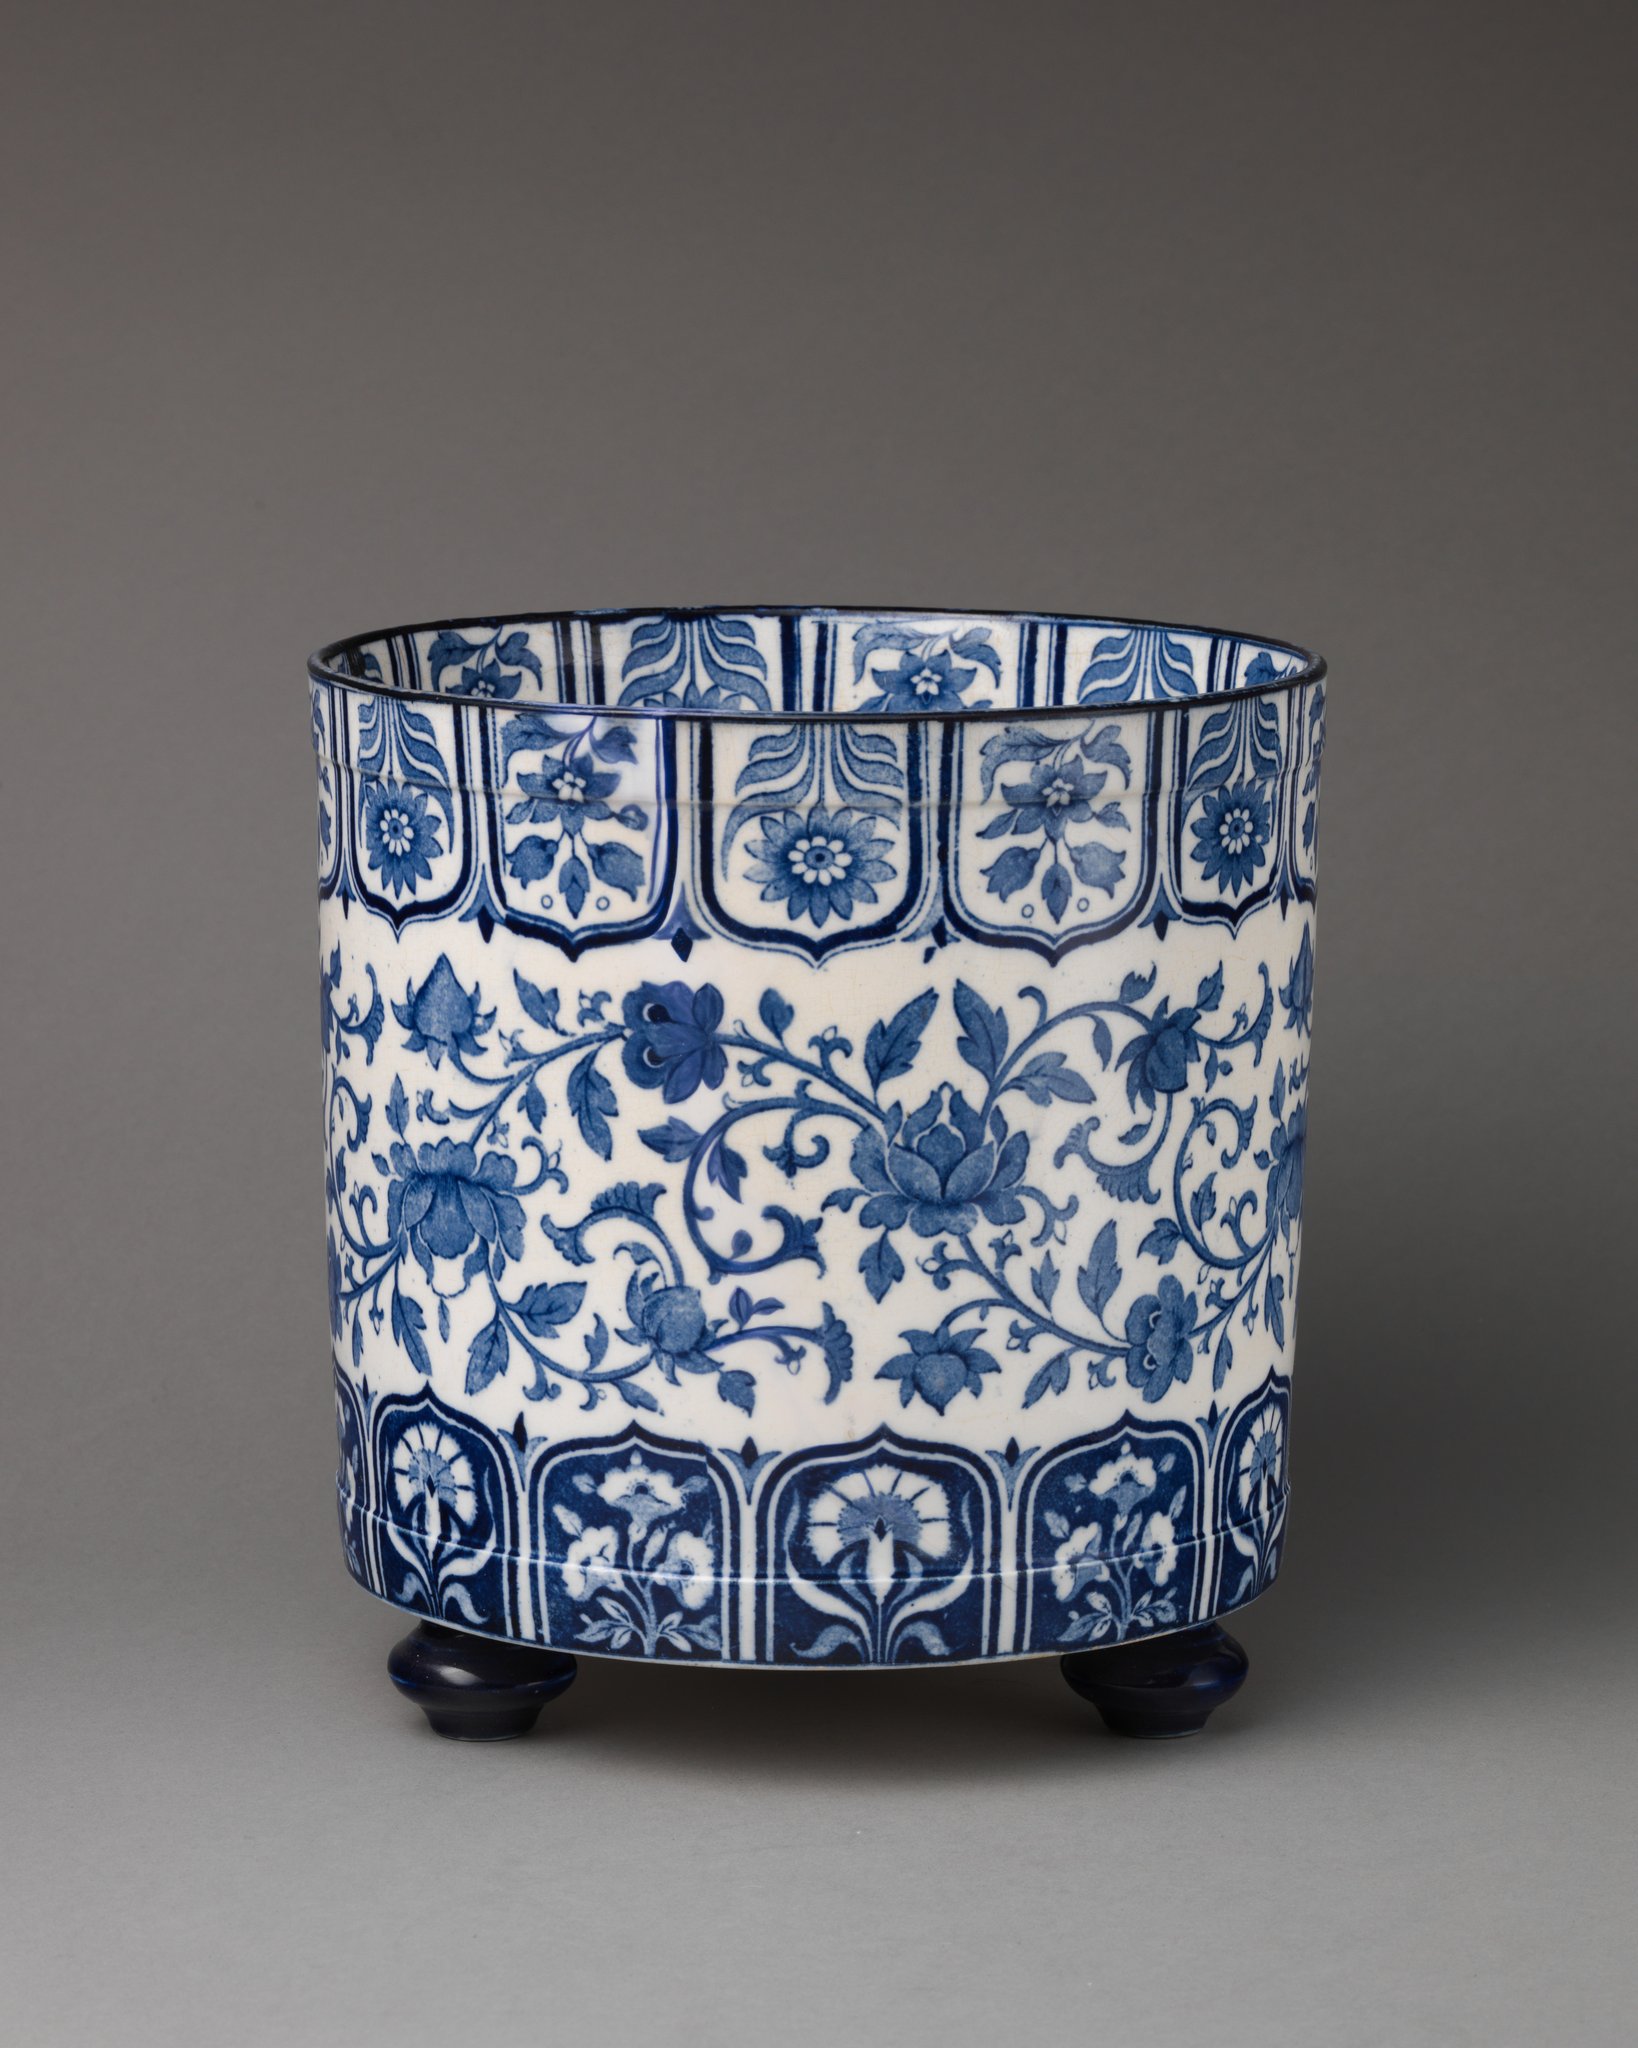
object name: jardinière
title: Footed jardinière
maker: minton(s)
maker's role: maker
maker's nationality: british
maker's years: 1793-2001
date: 1882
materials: bone china